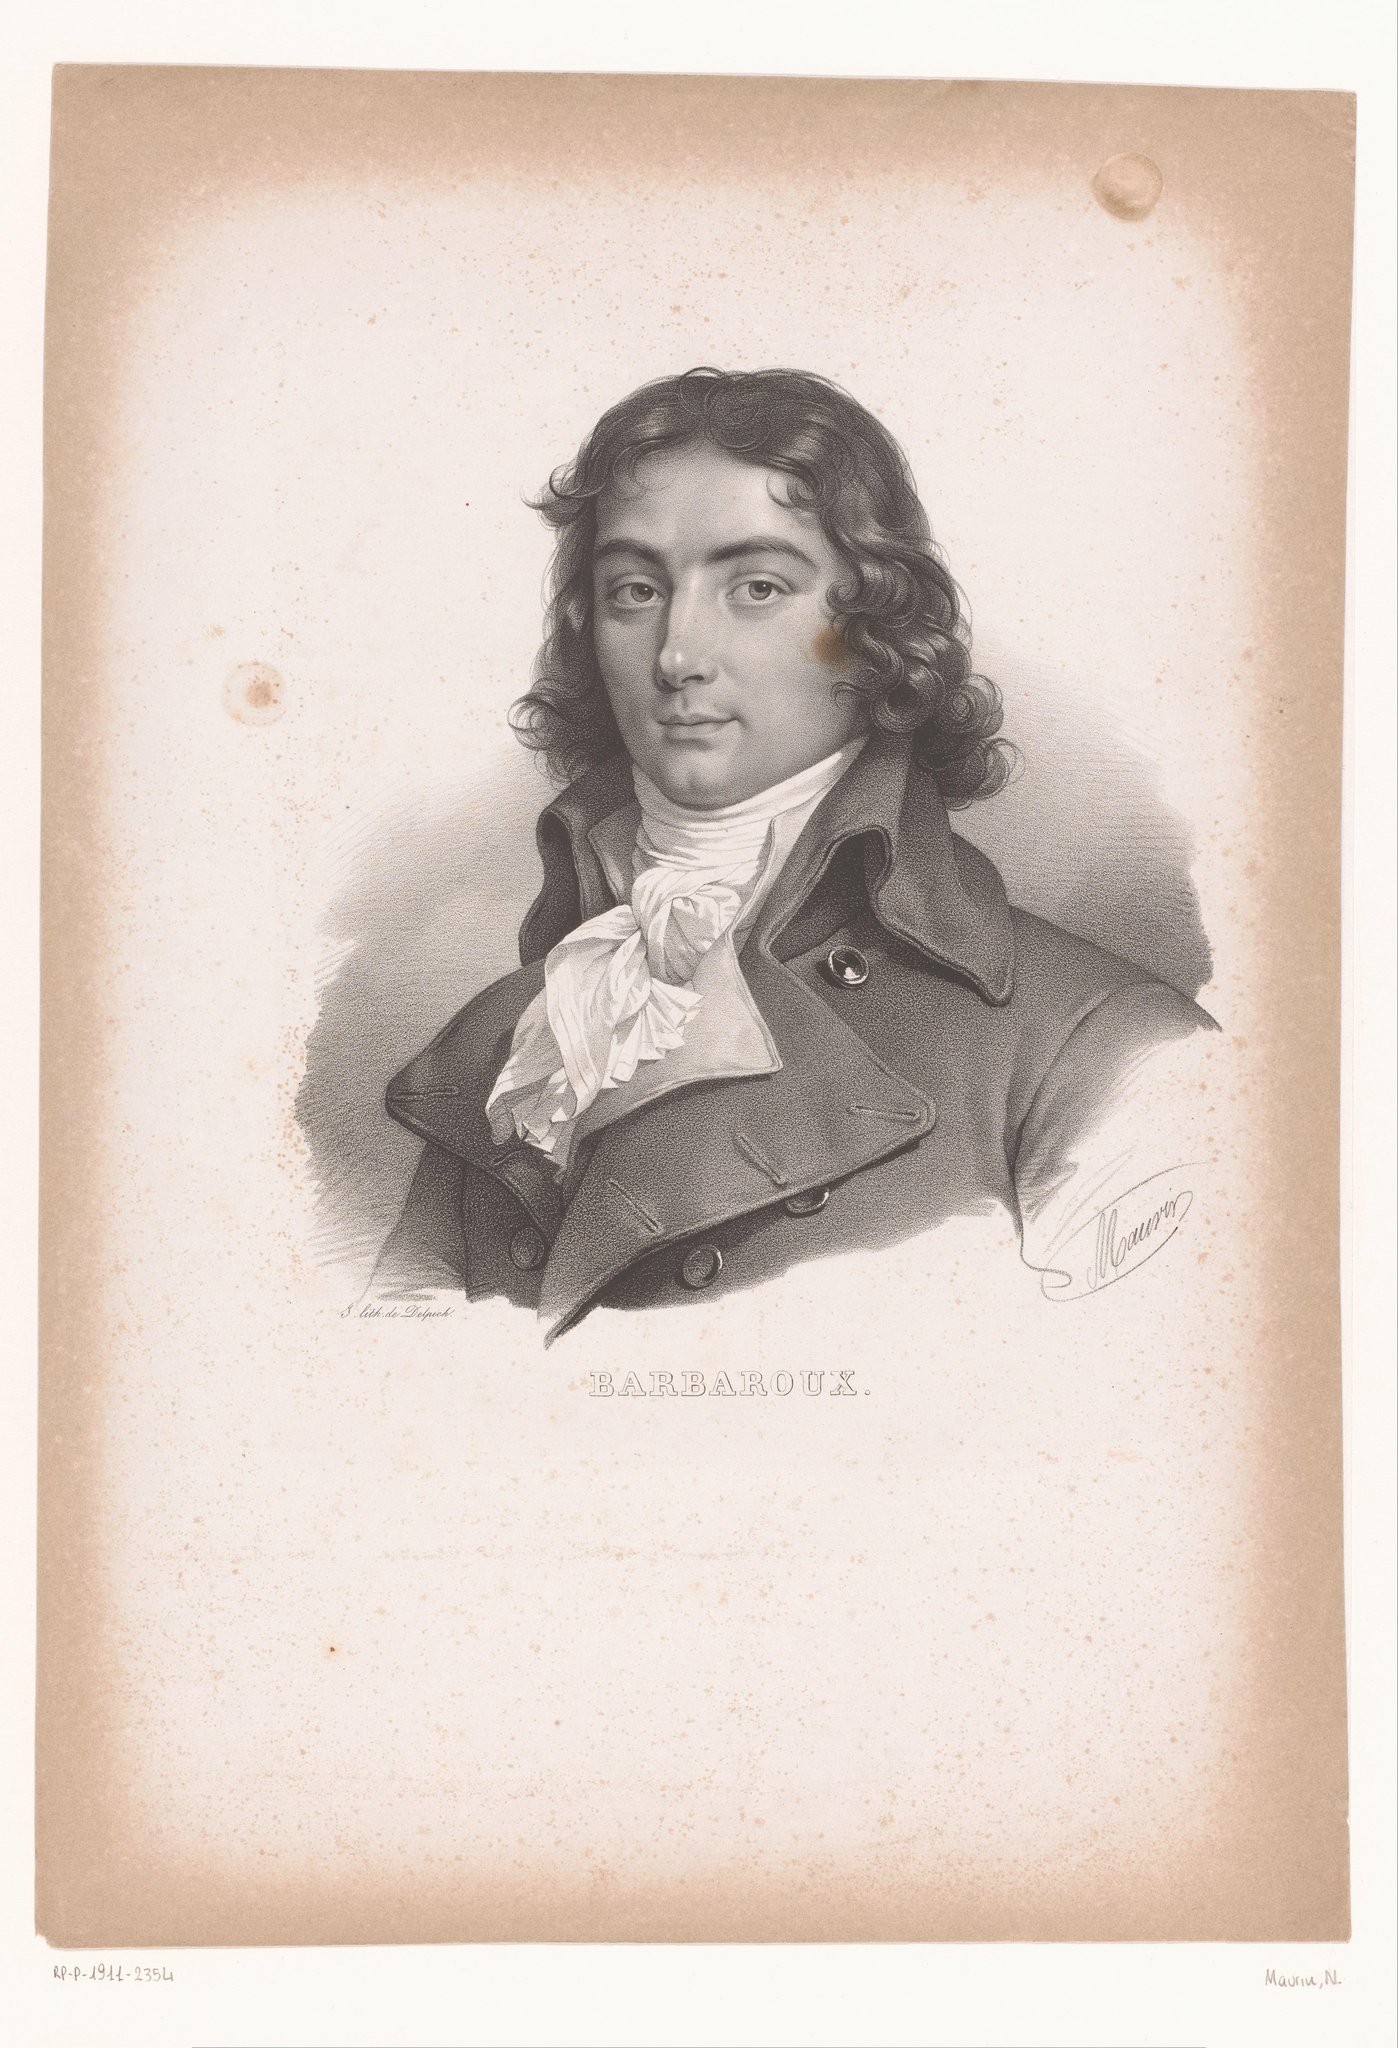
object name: print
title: Portret van Charles Barbaroux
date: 1825-1842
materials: paper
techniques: lithograph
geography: paris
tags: politician, historical persons, politician, e.g. party leader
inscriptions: collector's mark: Lugt 2228